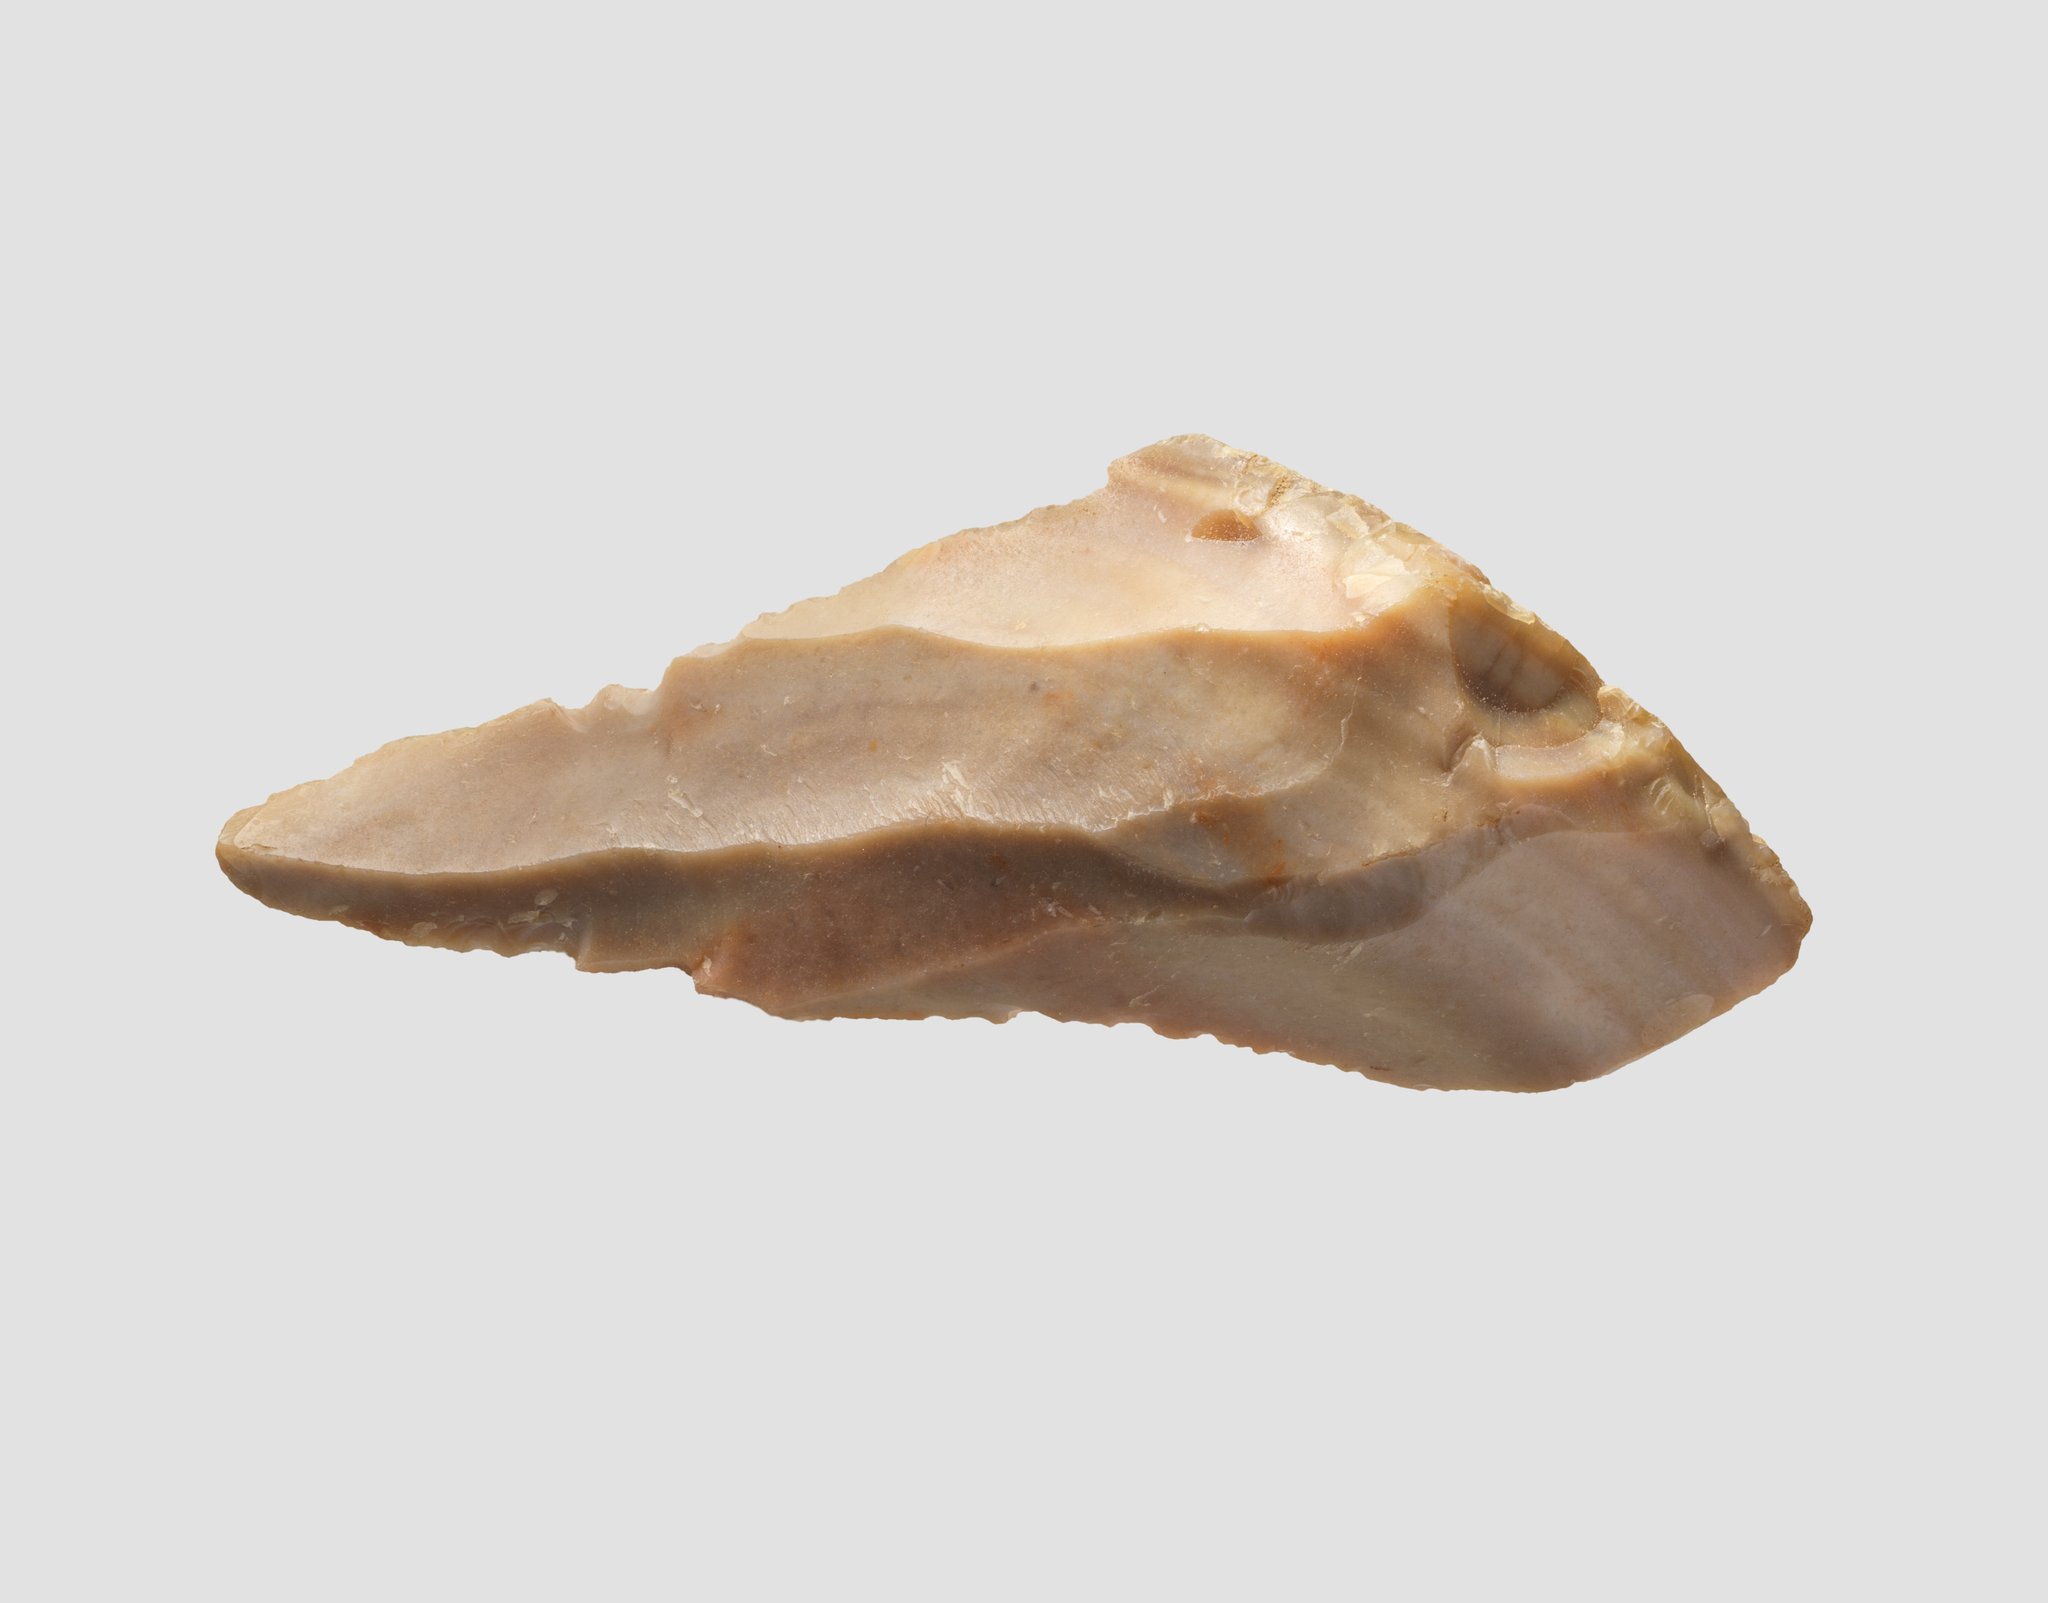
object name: borer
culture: ghassulian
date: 4600-3600 BCE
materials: stone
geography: levant